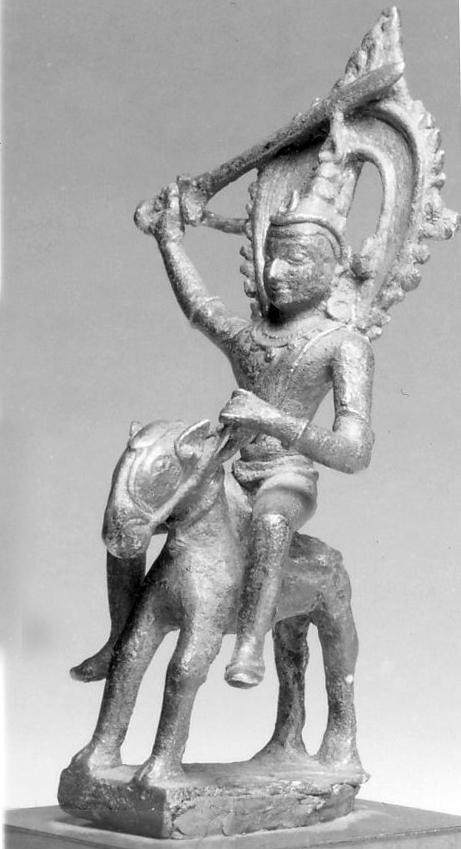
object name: figure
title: Kalki on Horseback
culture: bangladeshi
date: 901-1000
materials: bronze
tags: men,horses